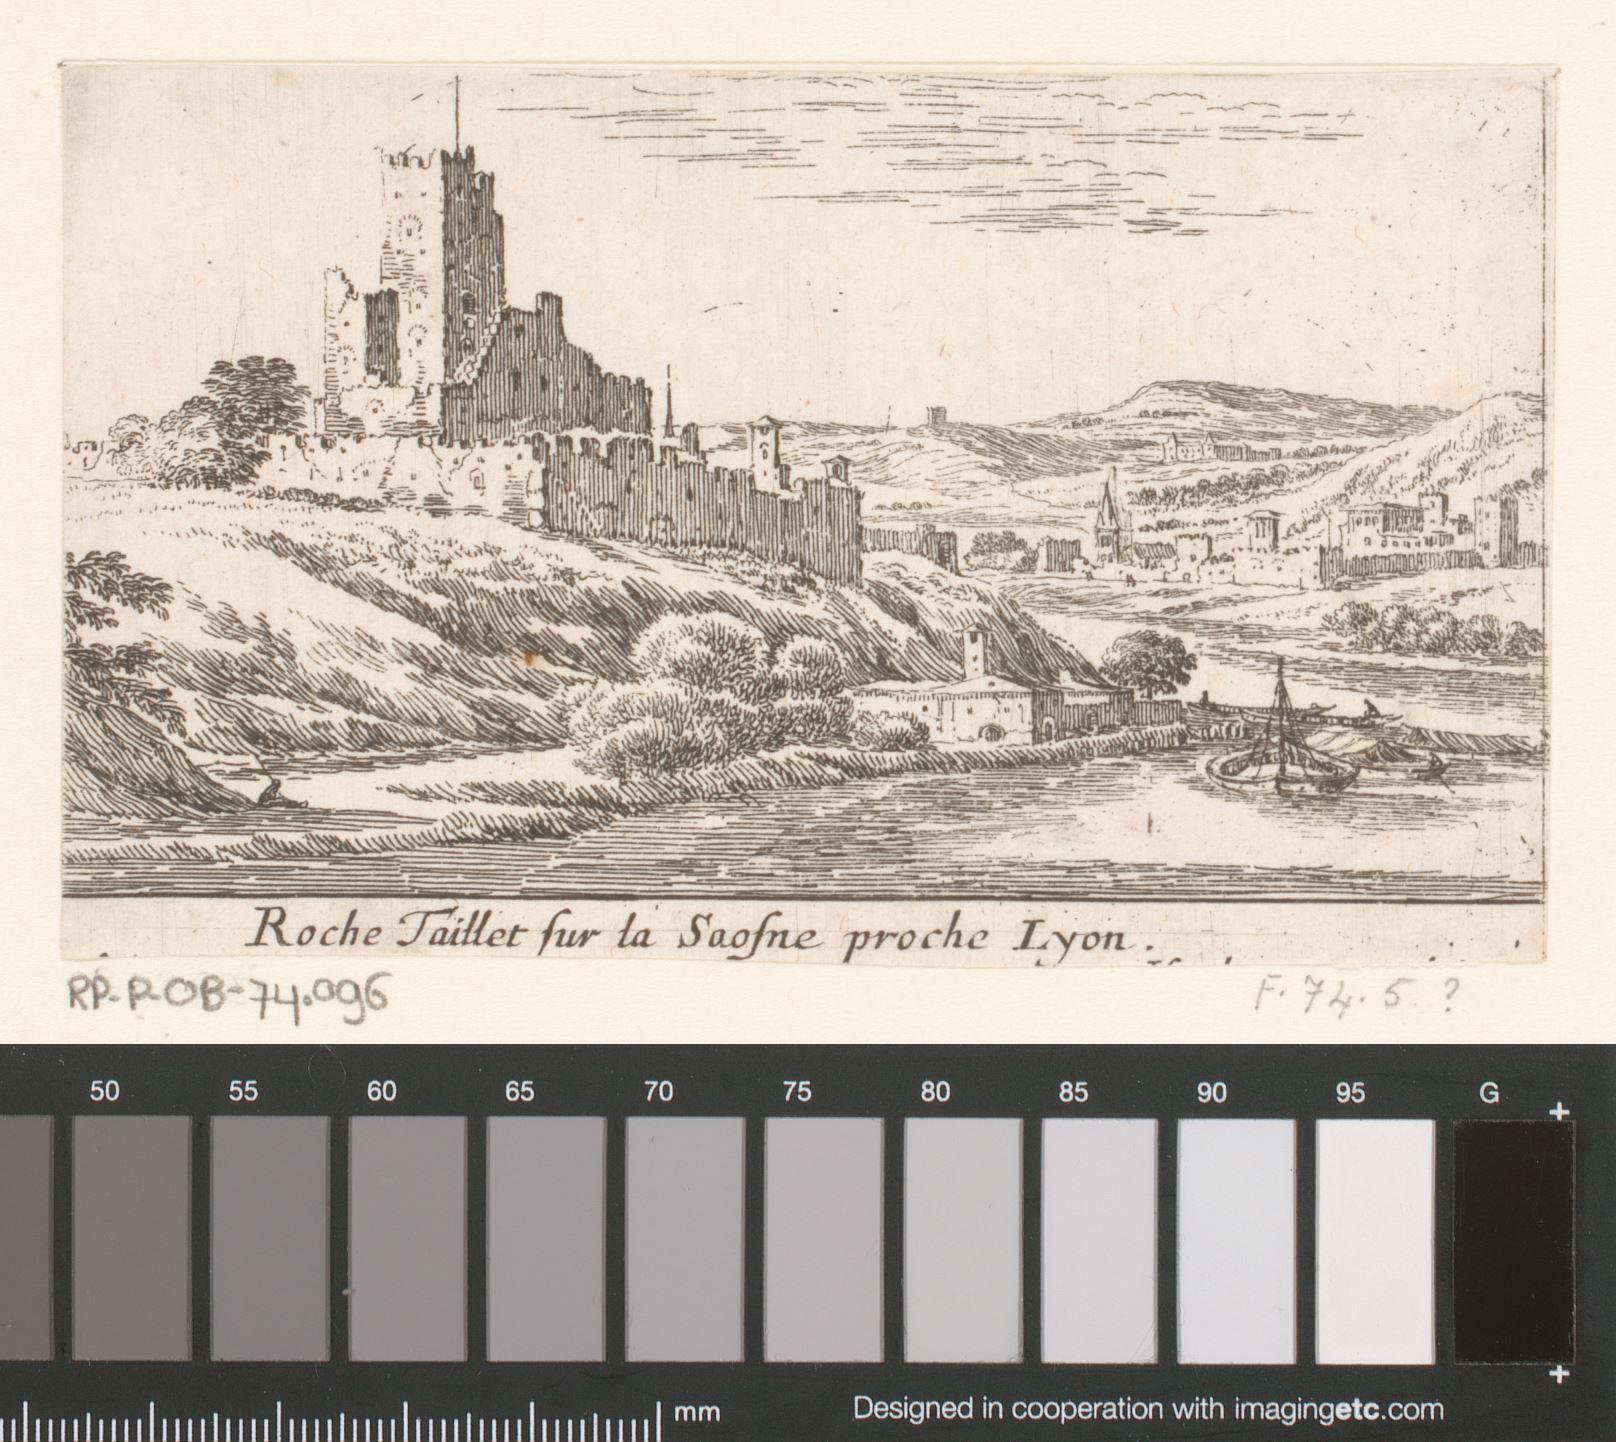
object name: print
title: Gezicht op kasteel aan de Seine bij Lyon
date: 1631-1661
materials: paper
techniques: etching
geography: france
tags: landscape with tower or castle (+ city(-scape) with figures, staffage)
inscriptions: collector's mark: Lugt 240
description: Prent maakt deel uit van een ongenummerde serie van zeven prenten.